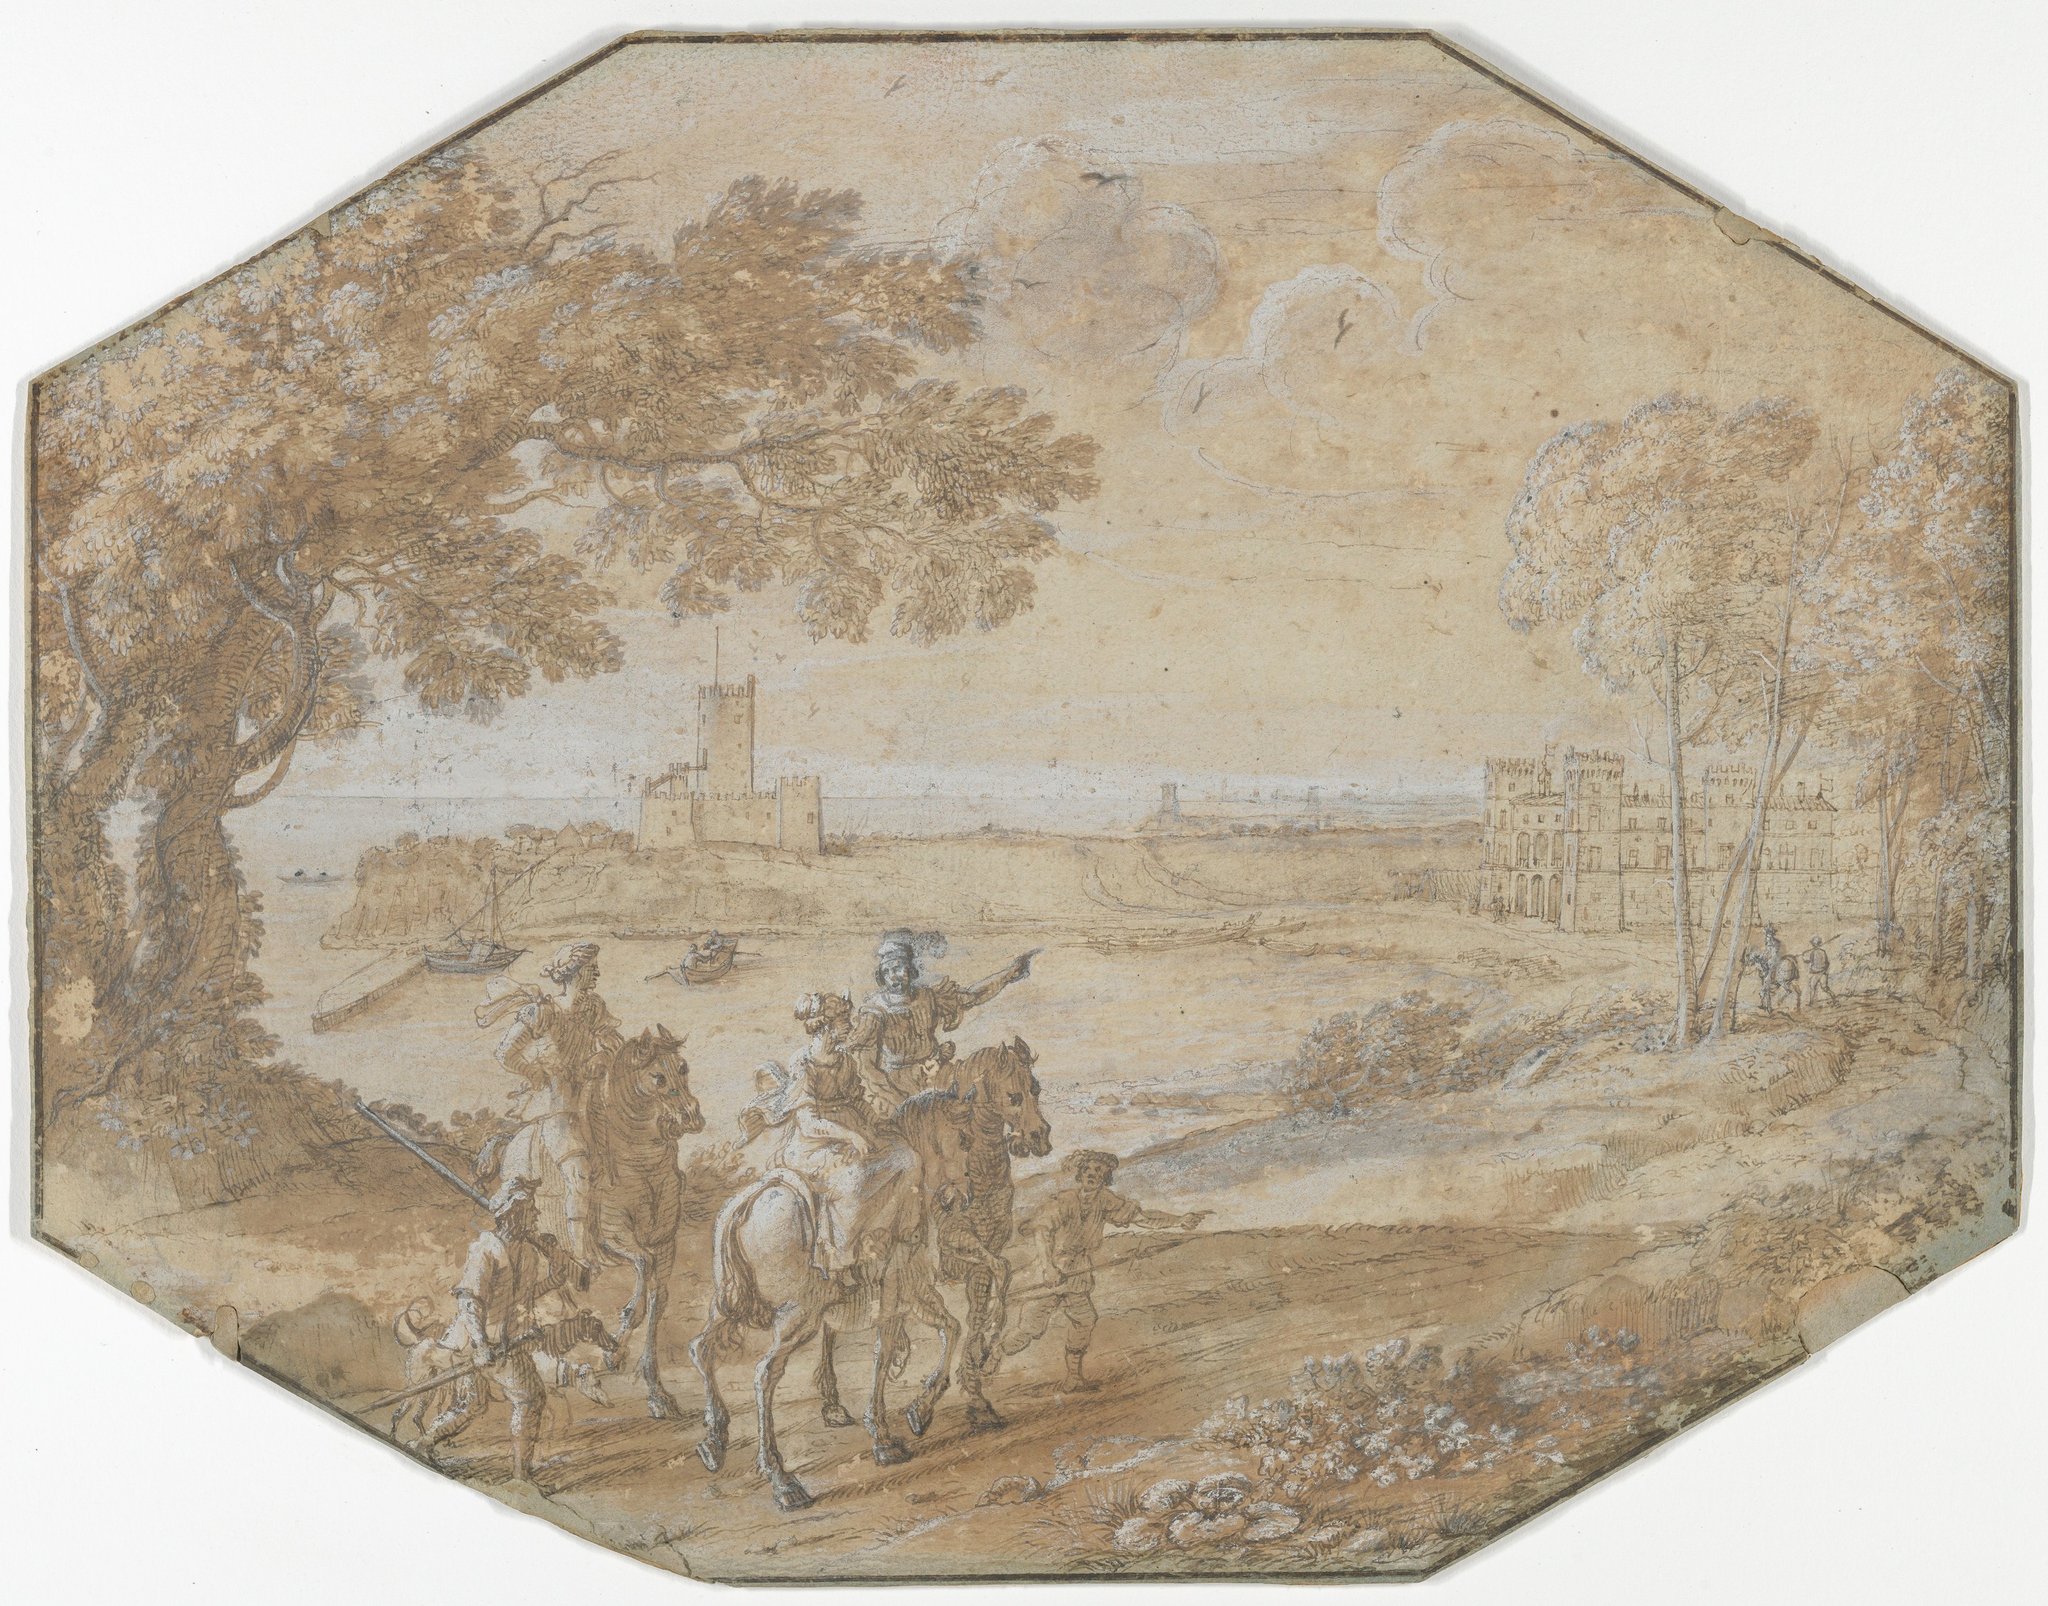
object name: drawing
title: Coast Scene with the Port of Santa Marinella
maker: claude lorrain (claude gellée)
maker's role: artist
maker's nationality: french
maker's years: 1604-1682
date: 1638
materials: chalk, ink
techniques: brush, heightening, pen, wash